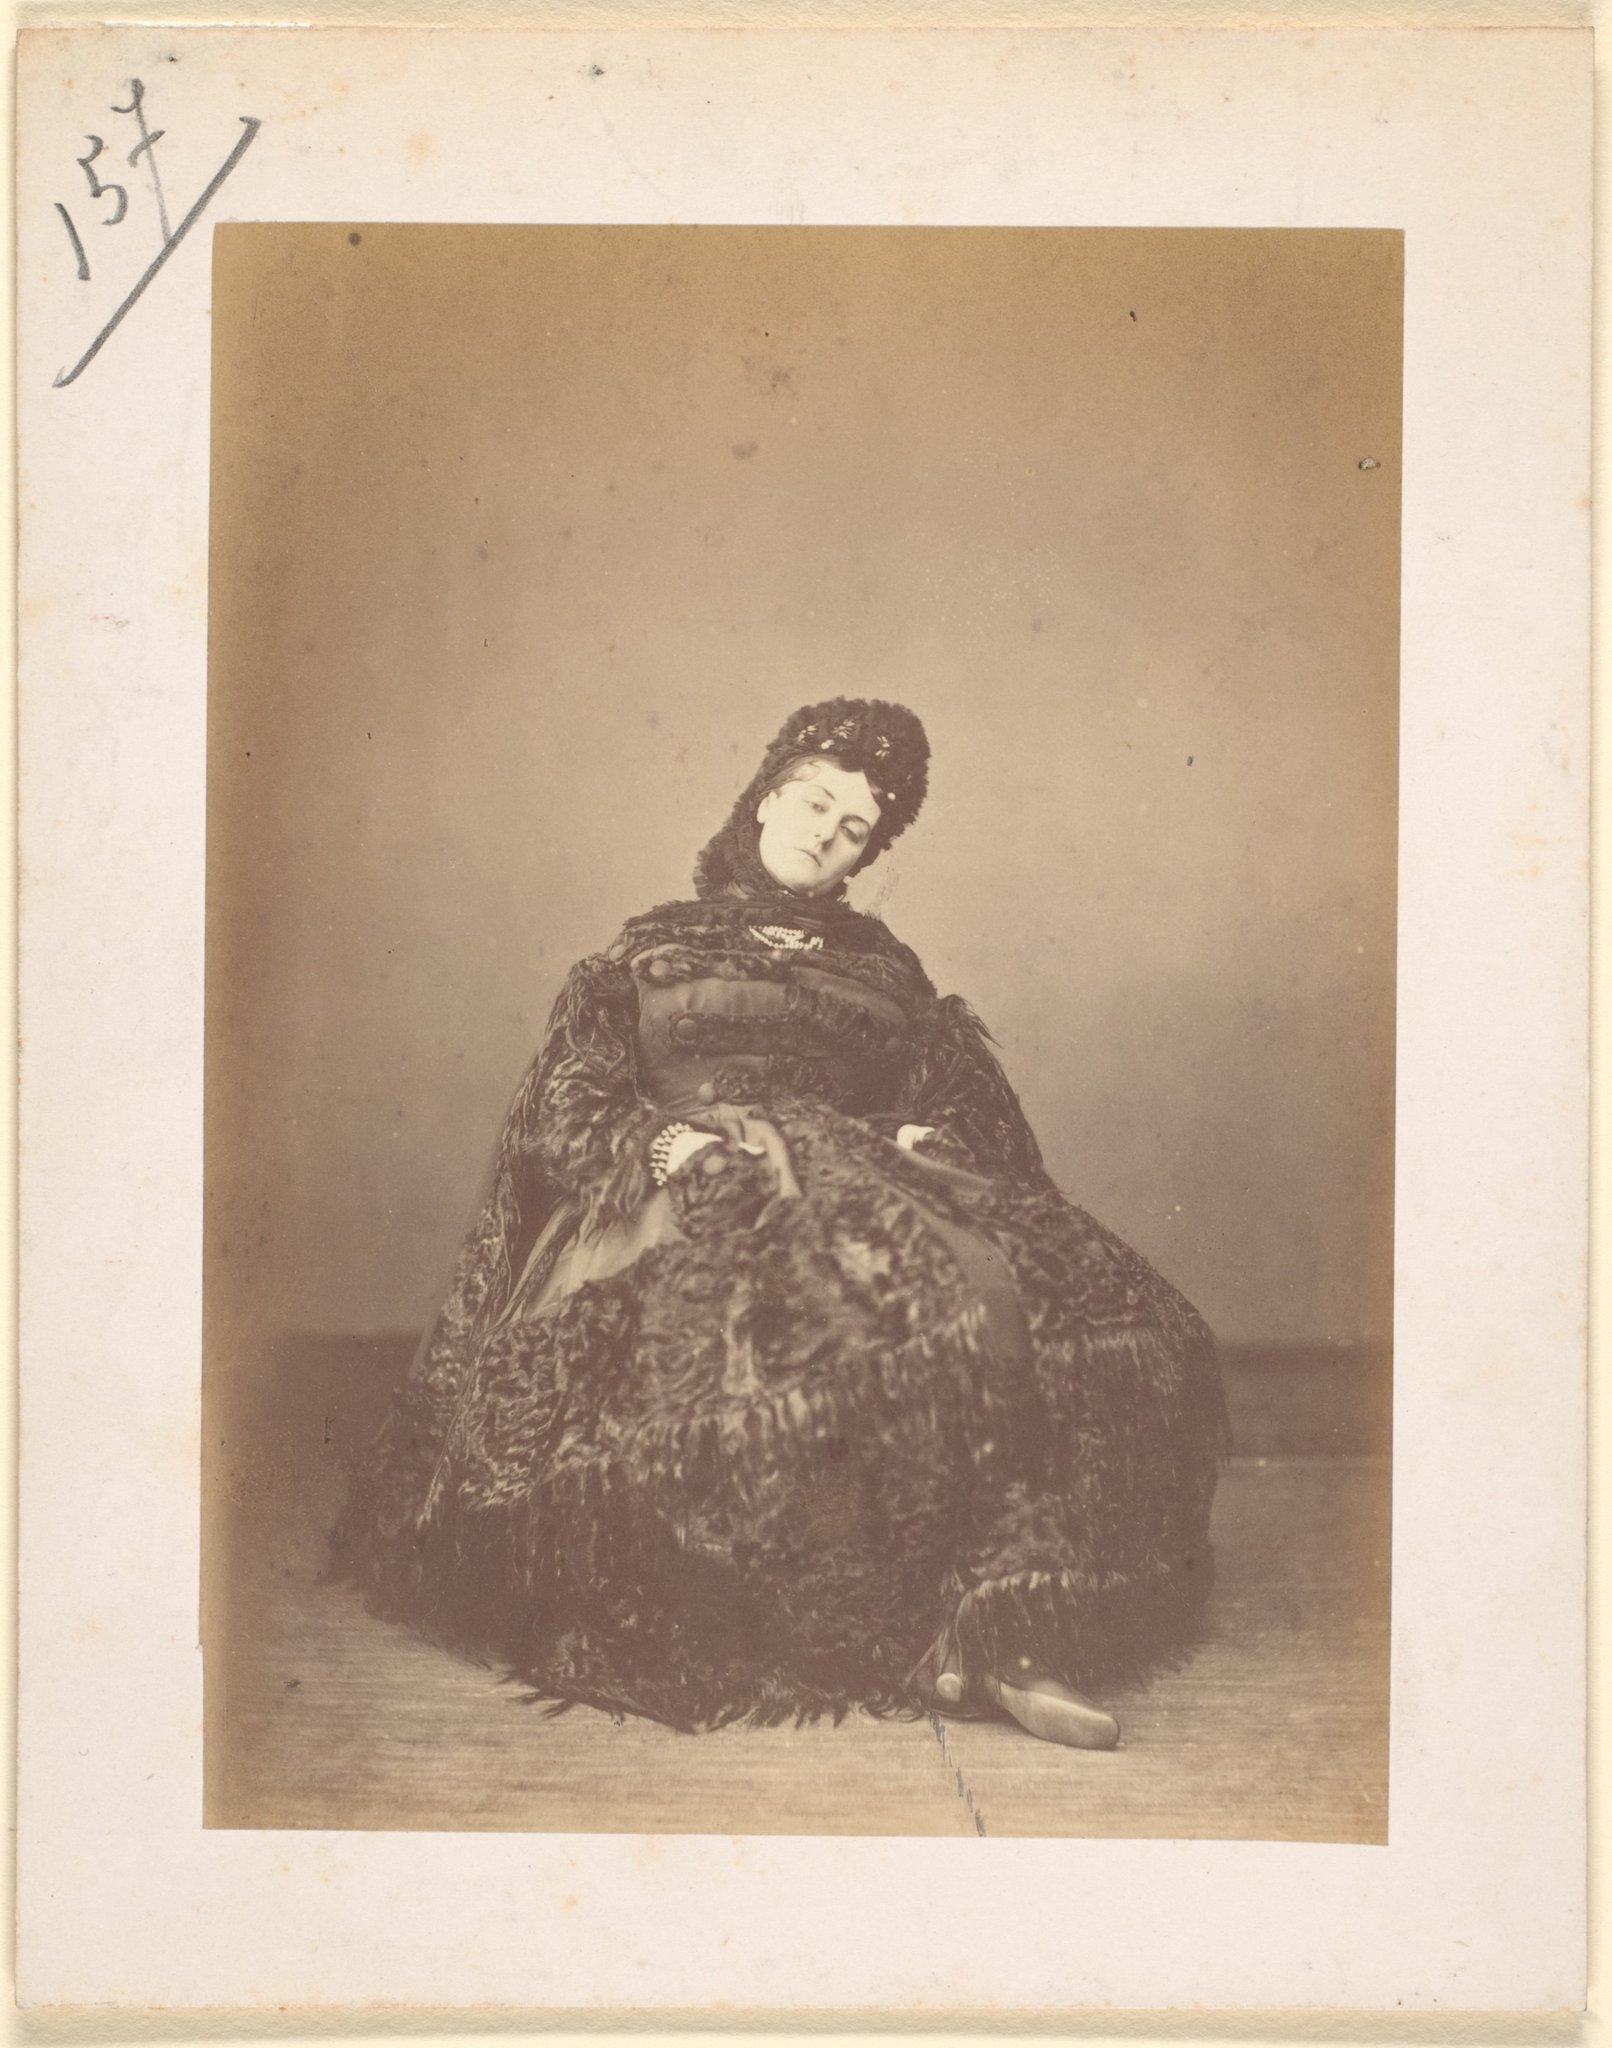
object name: photograph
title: Le Caracul (L'Astrakhan)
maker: pierre-louis pierson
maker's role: artist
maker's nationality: french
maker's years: 1822-1913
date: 1860-1869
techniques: albumen silver print, glass negative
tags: portraits,women